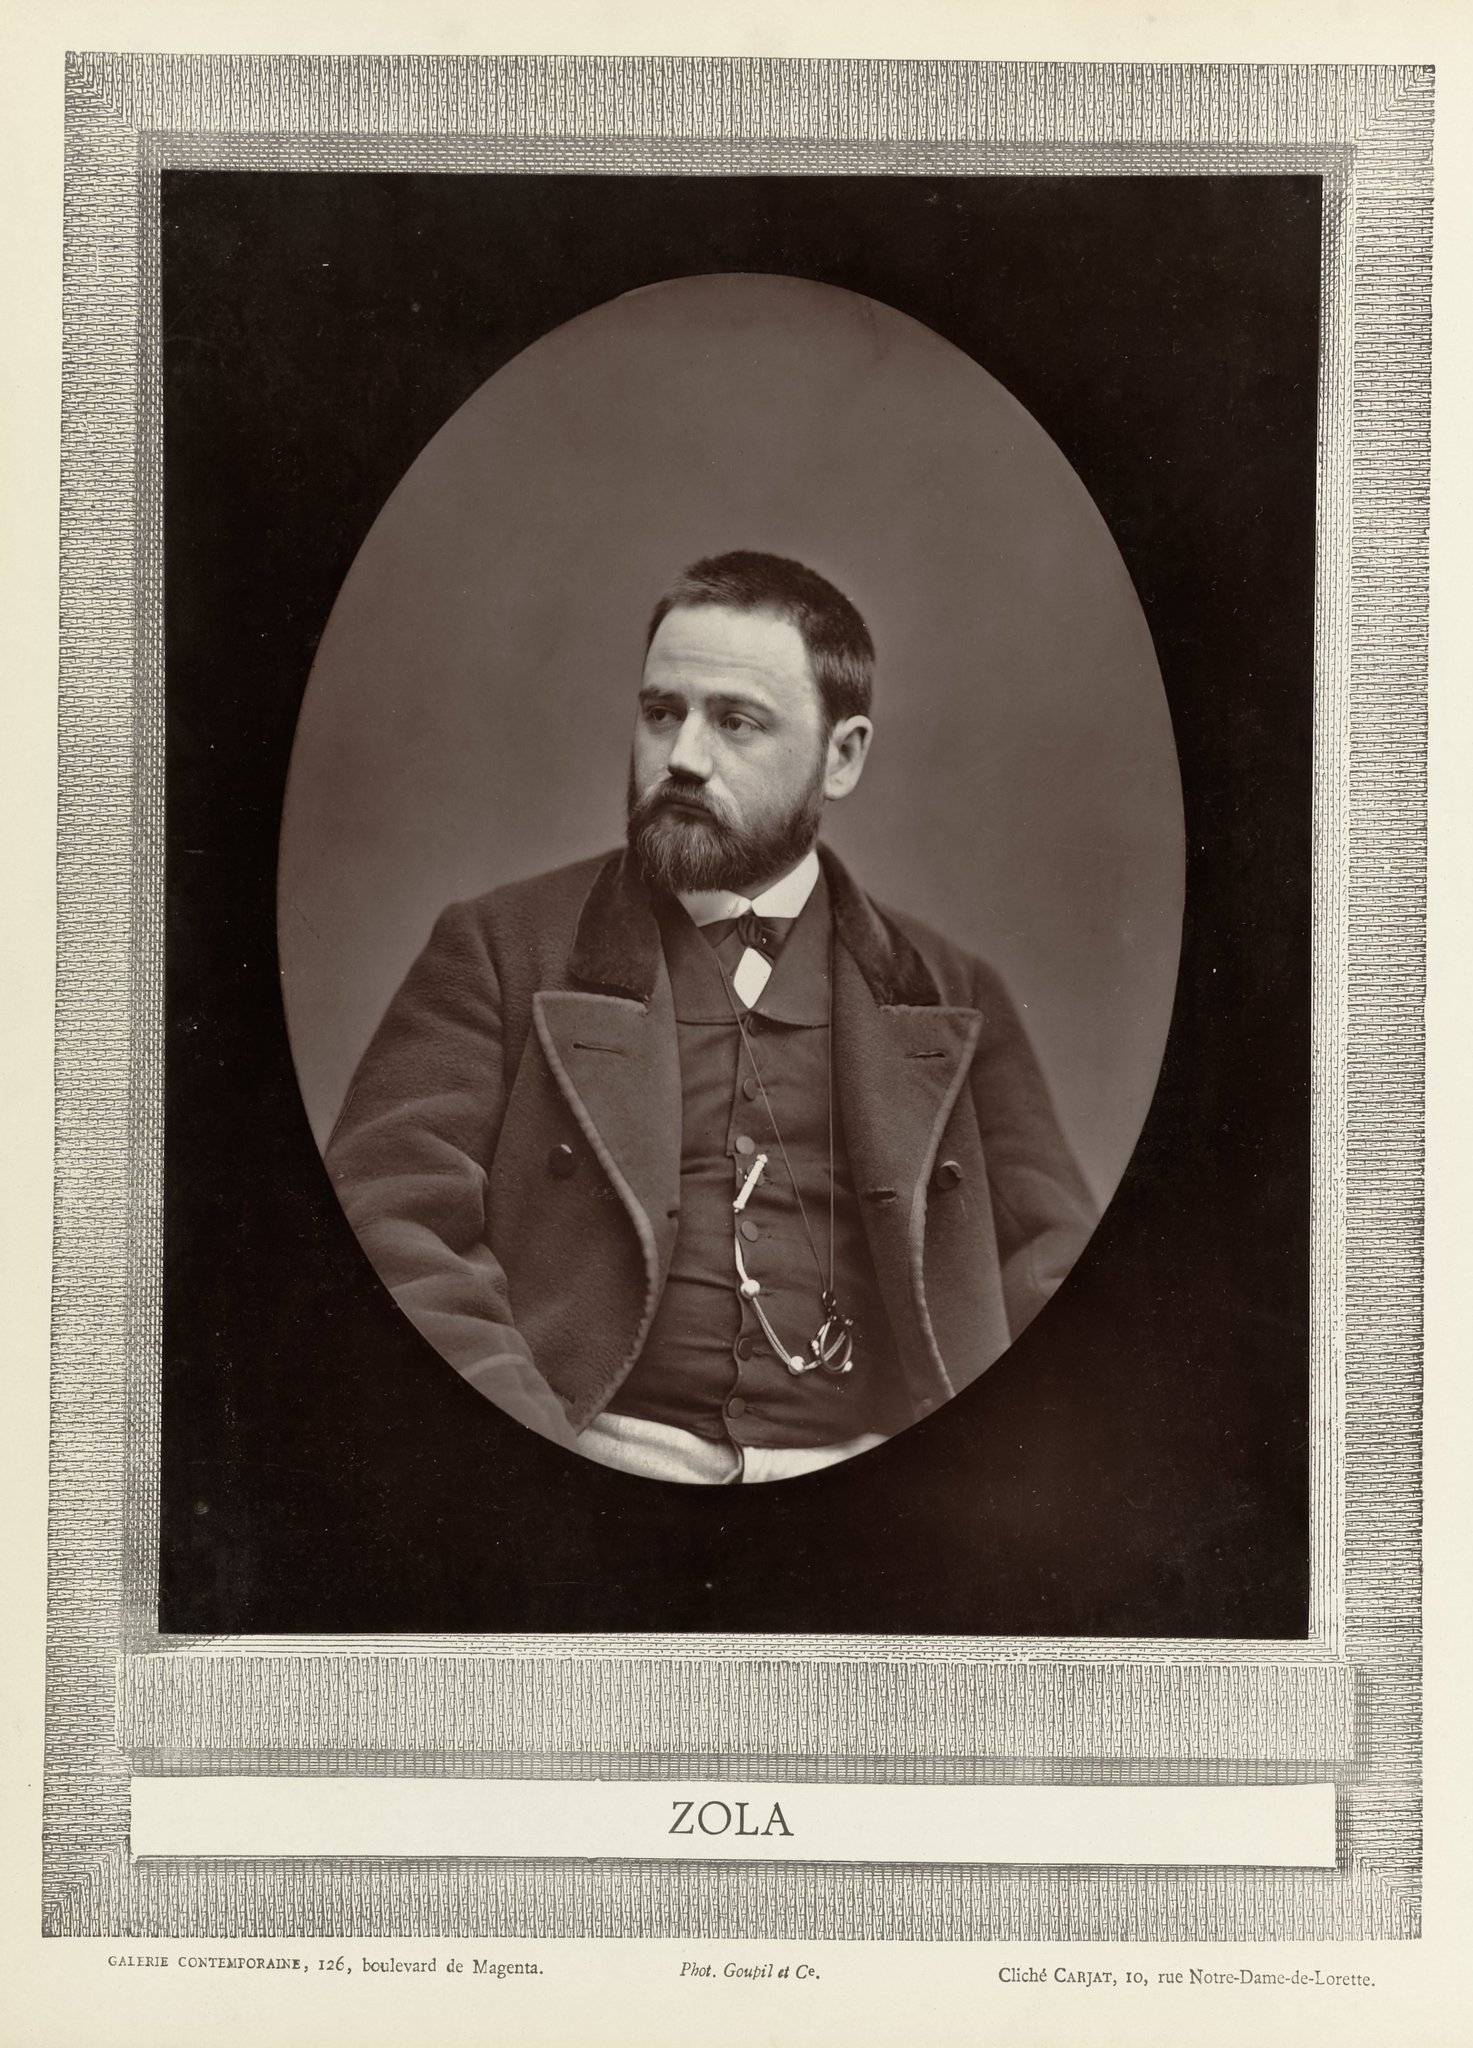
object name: page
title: Zola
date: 1872-1877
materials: paper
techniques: printing block, woodburytype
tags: paris, emile zola, adult man, historical persons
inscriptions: inscription: ‘Galerie Contemporaine, 126, boulevard de Magenta.’